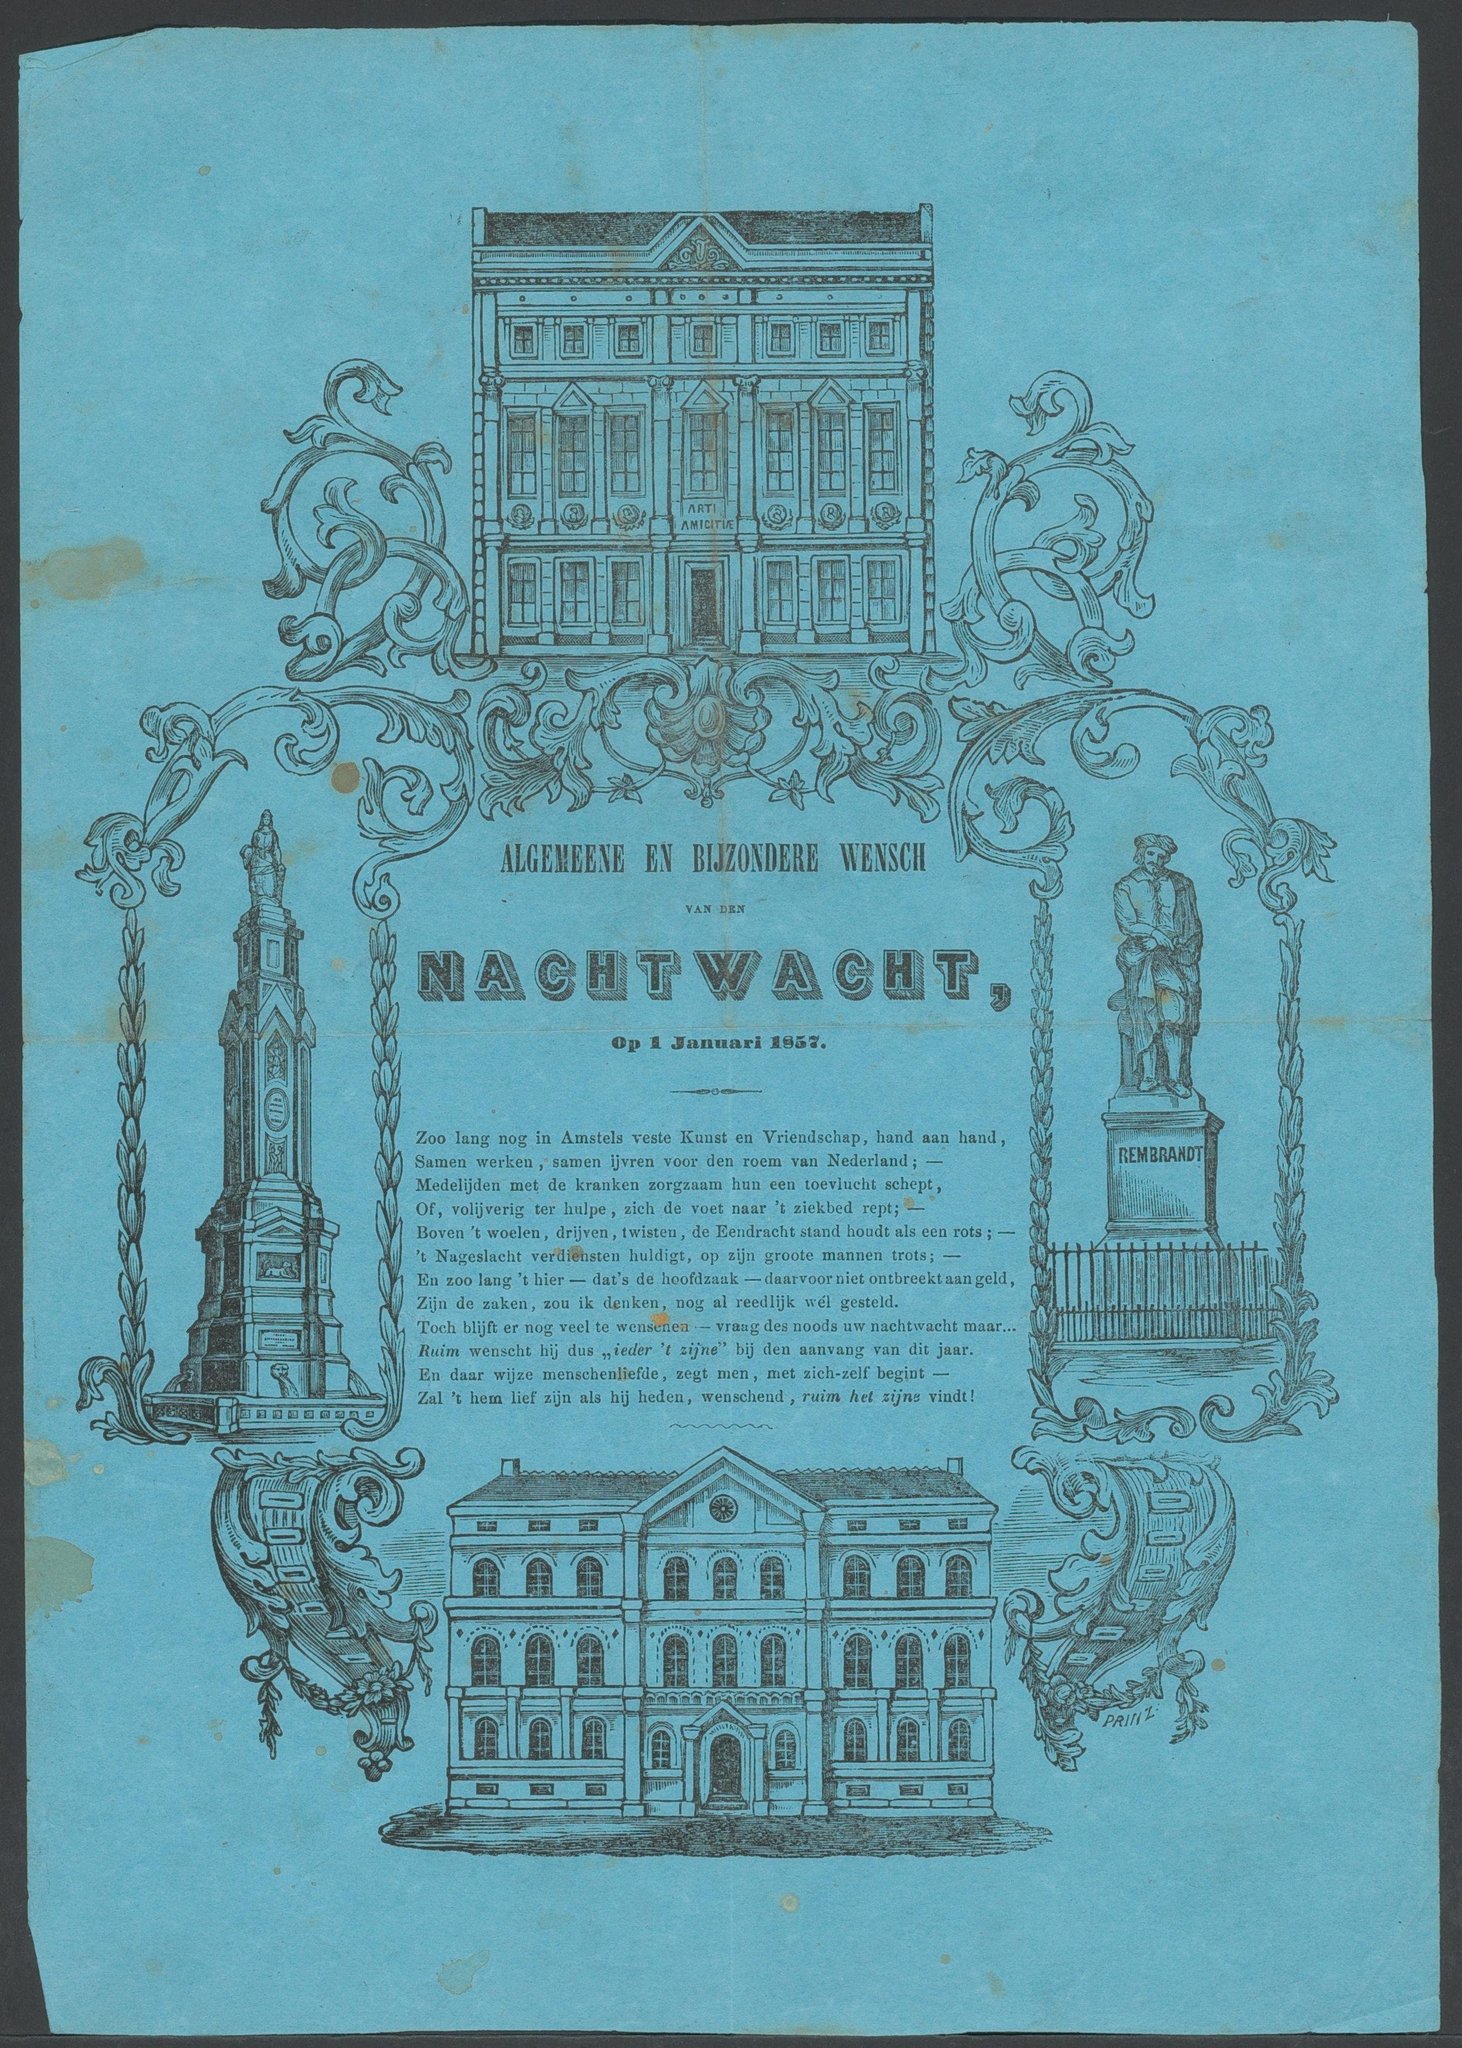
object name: new year card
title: Algemeene en bijzondere wensch van den Nachtwacht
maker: friedrich robert prinz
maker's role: print maker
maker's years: 1820-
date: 1856-1857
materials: paper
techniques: letterpress printing, engraving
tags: night patrol, tower, clock tower ~ monumental adornment, canal, monument, statue, amsterdam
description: Nieuwjaarswens van de Amsterdamse nachtwacht (ratelwacht) voor het jaar 1857. Centraal een gedicht in drie verzen, daaromheen de gebouwen van Arti et Amicitiae, standbeeld van Naatje op de Dam, het standbeeld van Rembrandt en het nieuwe Prinsengrachtziekenhuis. Onderwerpsrubrieken binnen de Atlas Zeden en Gewoonten: Zeden en gewoonten in engeren zin, Volksleven, Volksbladen, Nieuwjaars- en Kerstwenschen, Amsterdam.